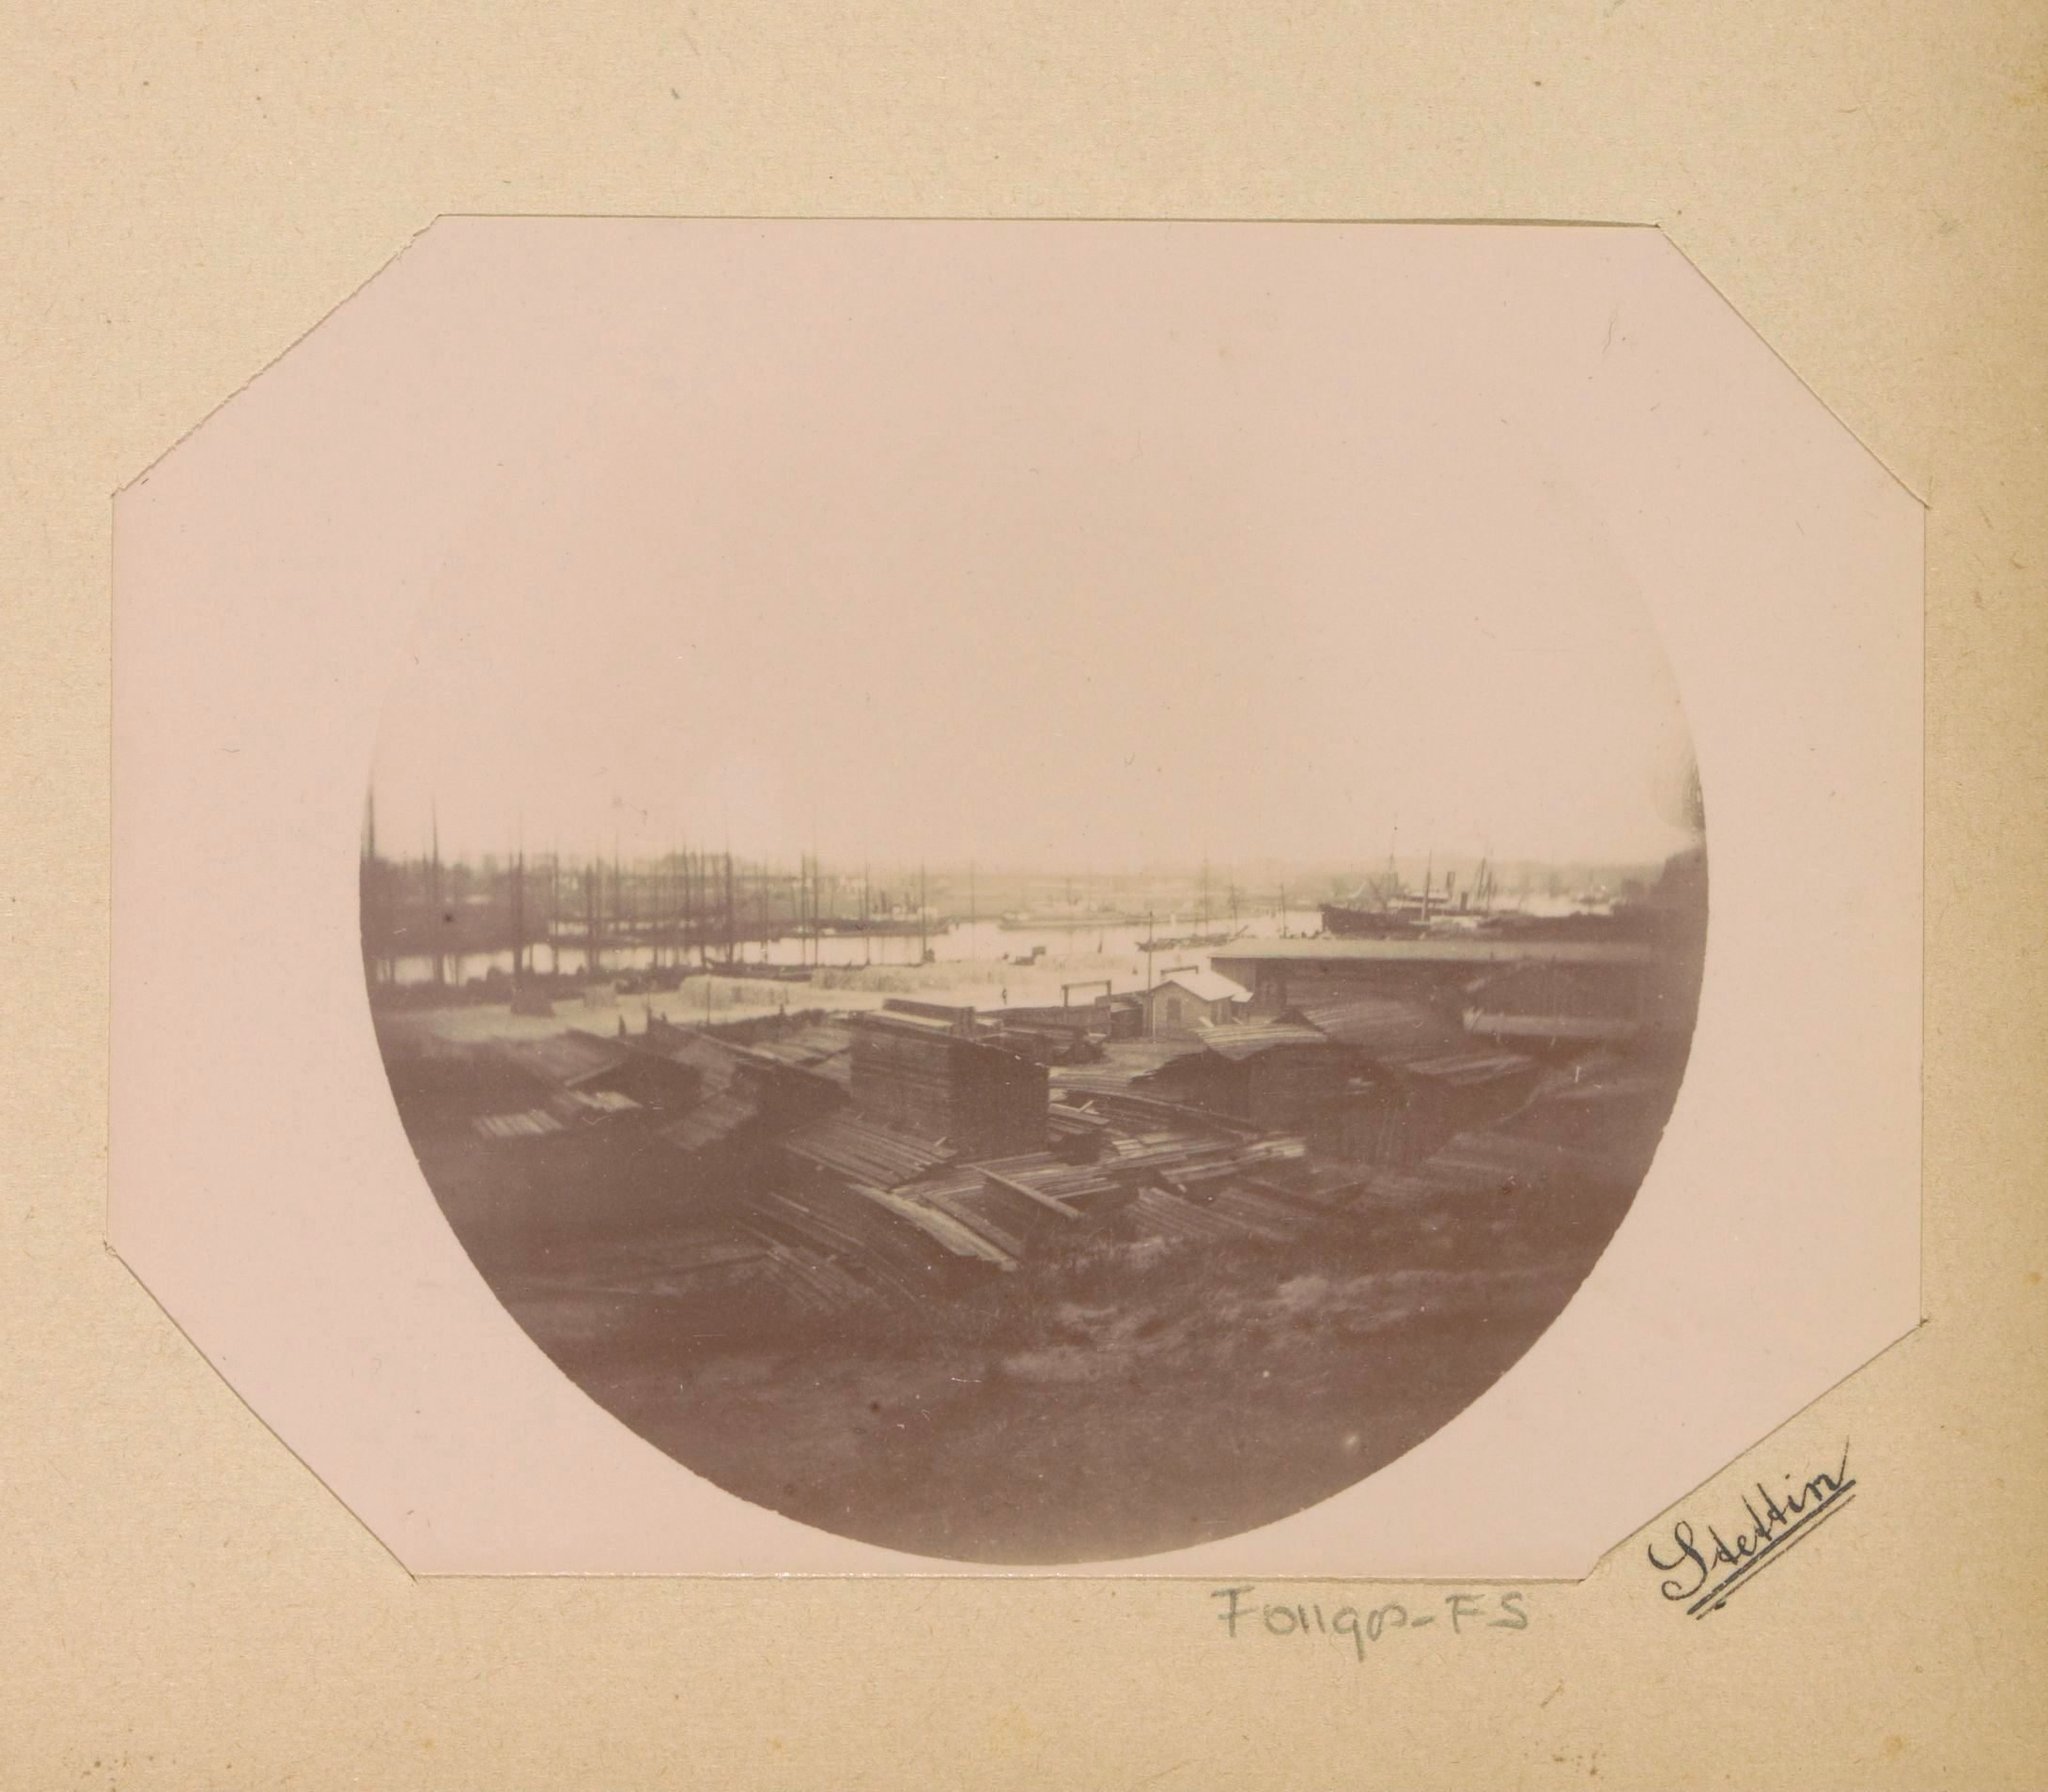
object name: photograph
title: Gezicht op de haven van Szczecin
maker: willem frederik piek jr.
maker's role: fotograaf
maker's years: 1874-1954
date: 1889-1893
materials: paper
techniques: gelatin silver print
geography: szczecin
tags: harbour